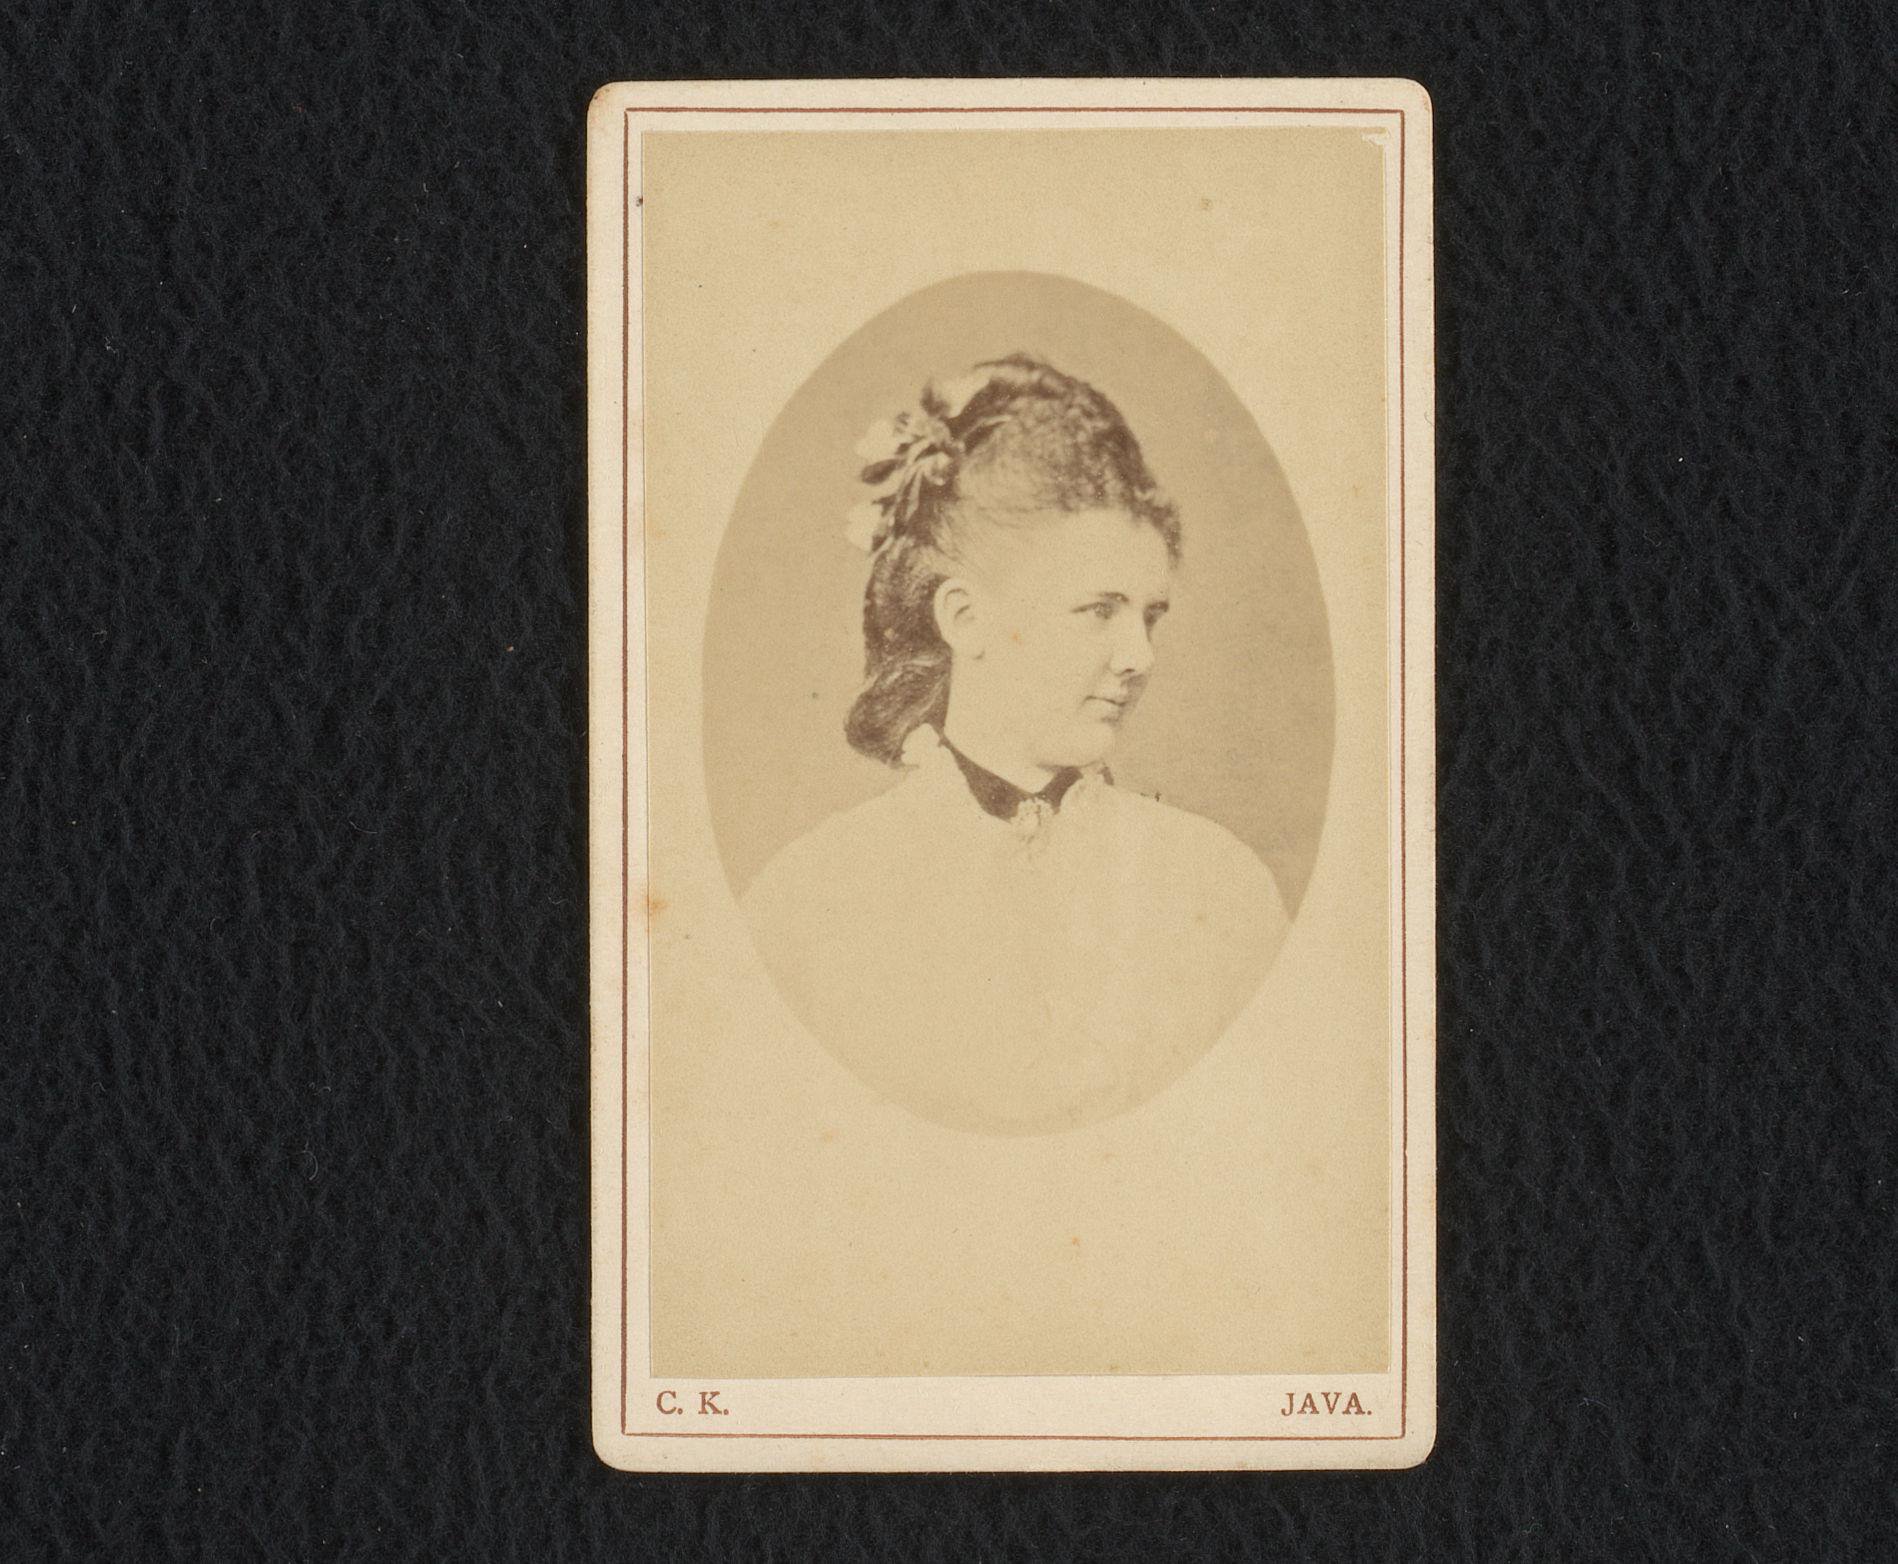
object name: photograph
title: Fotoreproductie van een fotoportret van koningin Emma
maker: c. krüger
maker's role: fotograaf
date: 1875-1880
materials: cardboard, paper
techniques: albumen print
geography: batavia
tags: the hague, emma (queen consort of the netherlands), historical persons - bb - woman